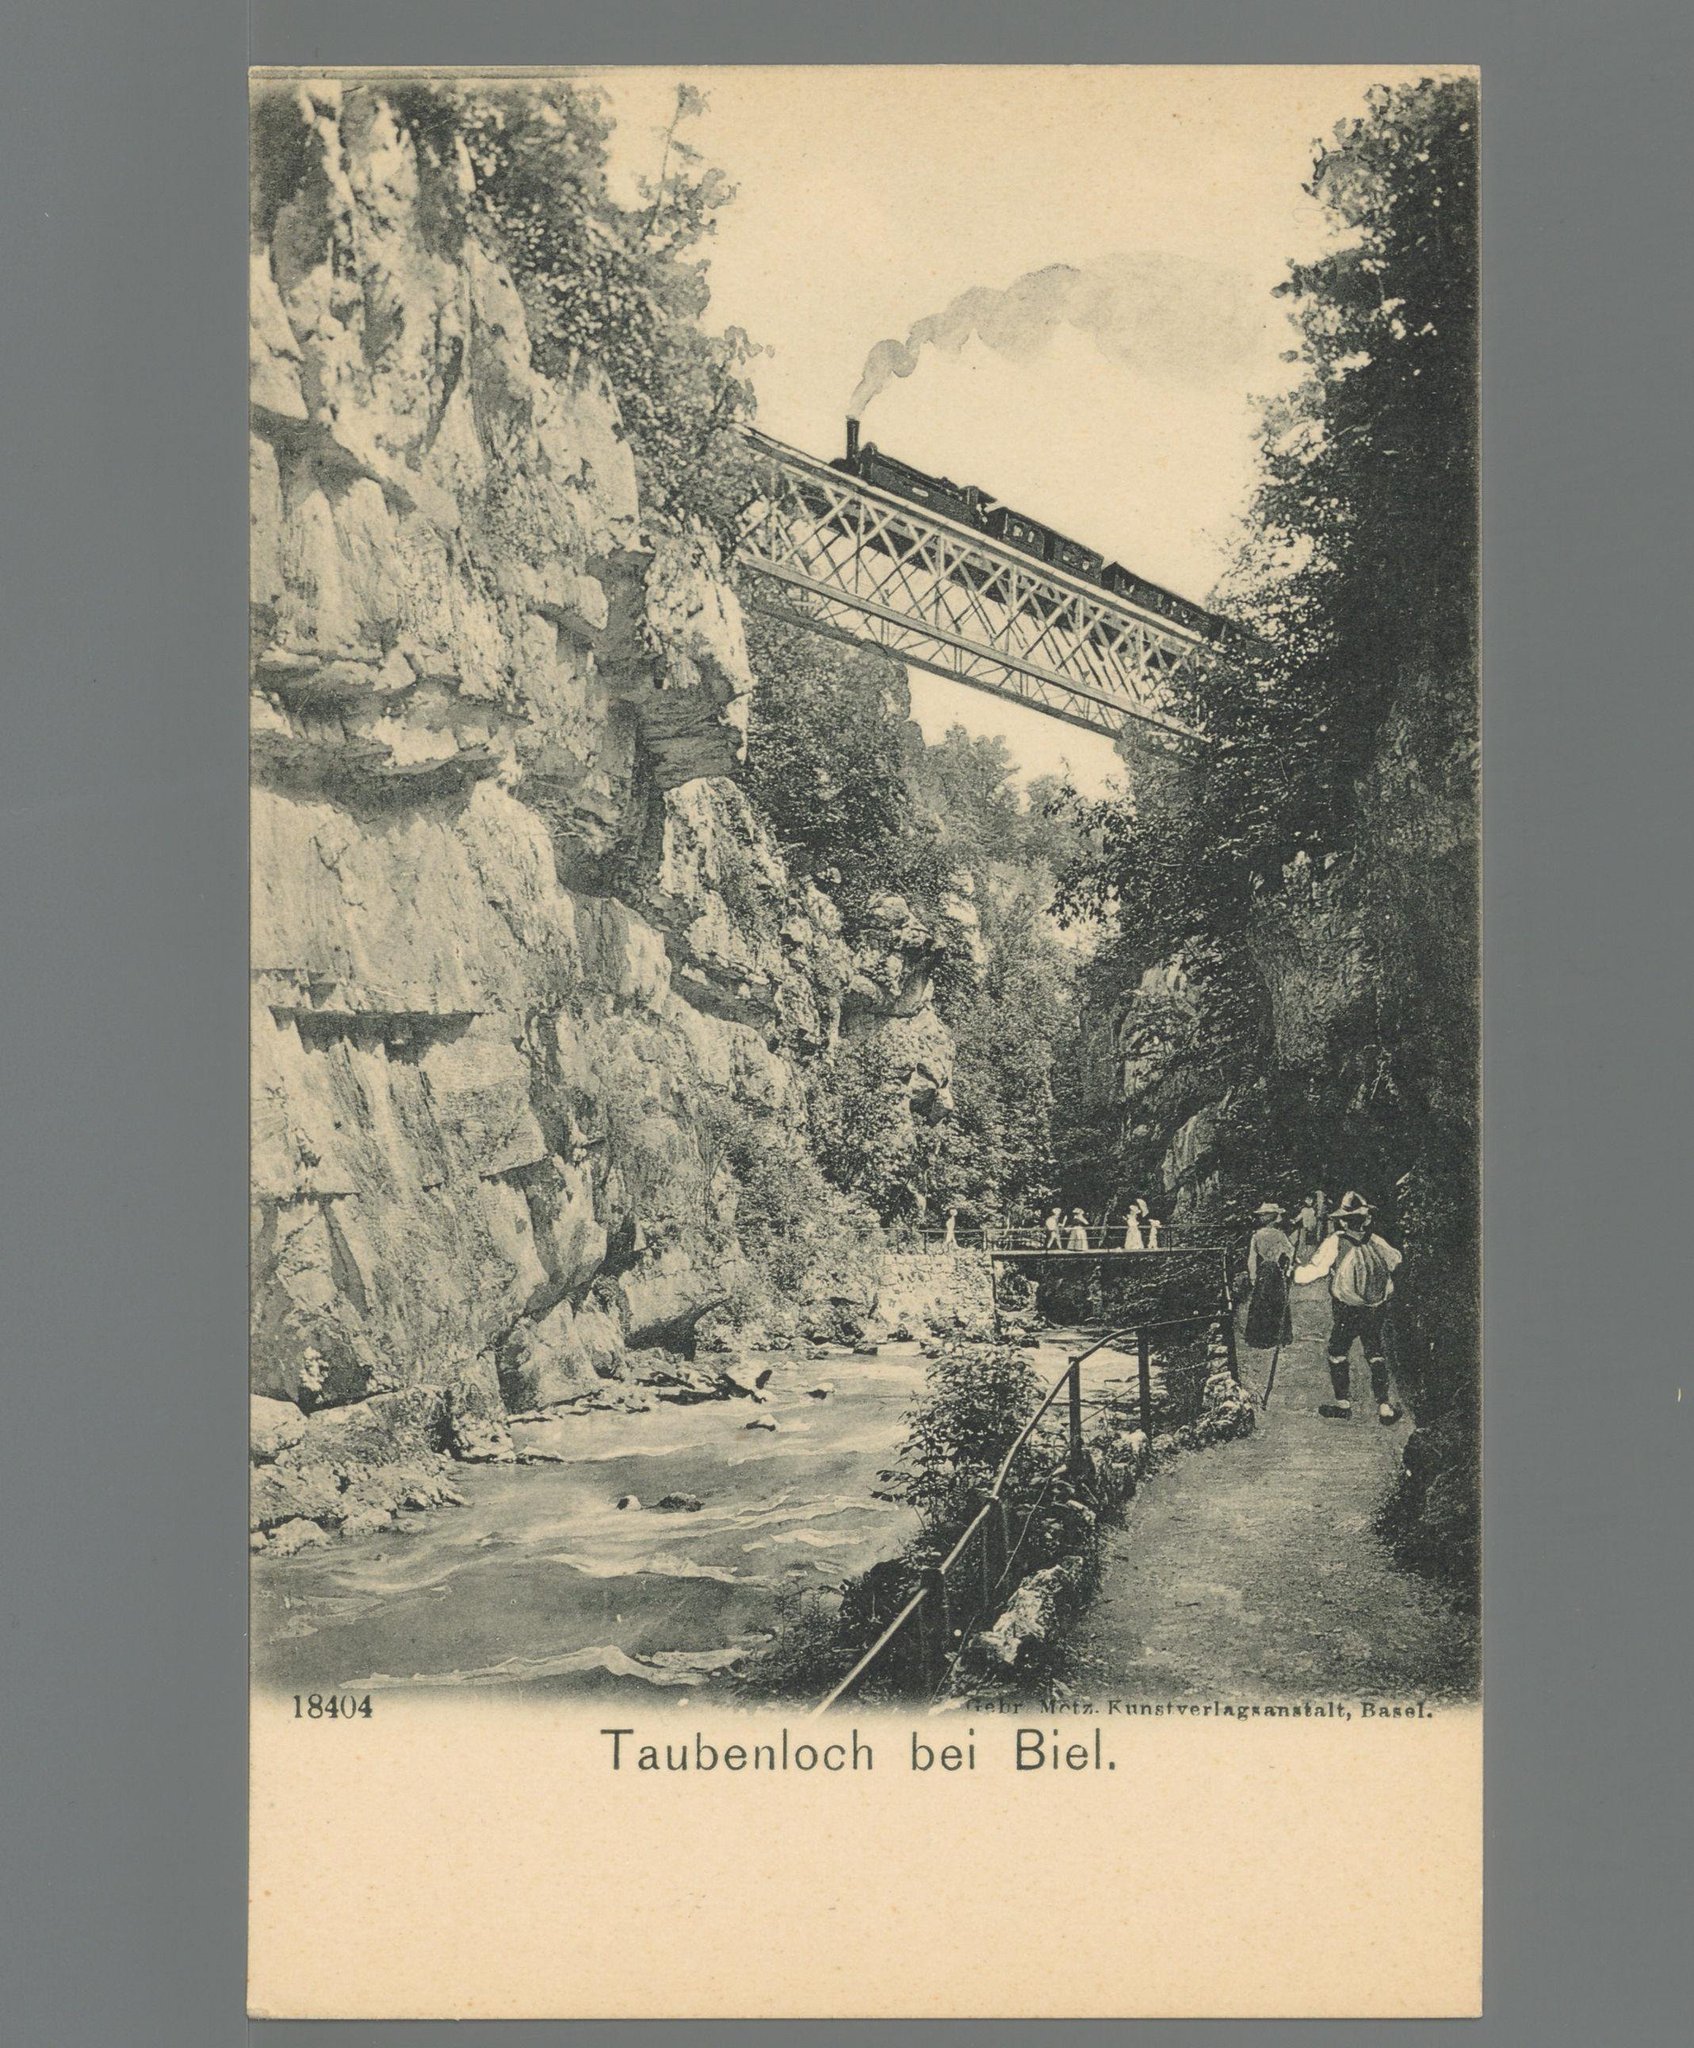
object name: ansichtkaart, prentbriefkaart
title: Taubenloch bei Biel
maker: Anonymous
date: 1897-1905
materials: cardboard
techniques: photograph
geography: biel/bienne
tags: passenger train, ravine, chasm, abyss, canyon (+ landscape with figures, staffage)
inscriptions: stamp: ‘Taubenloch. Bözingen’